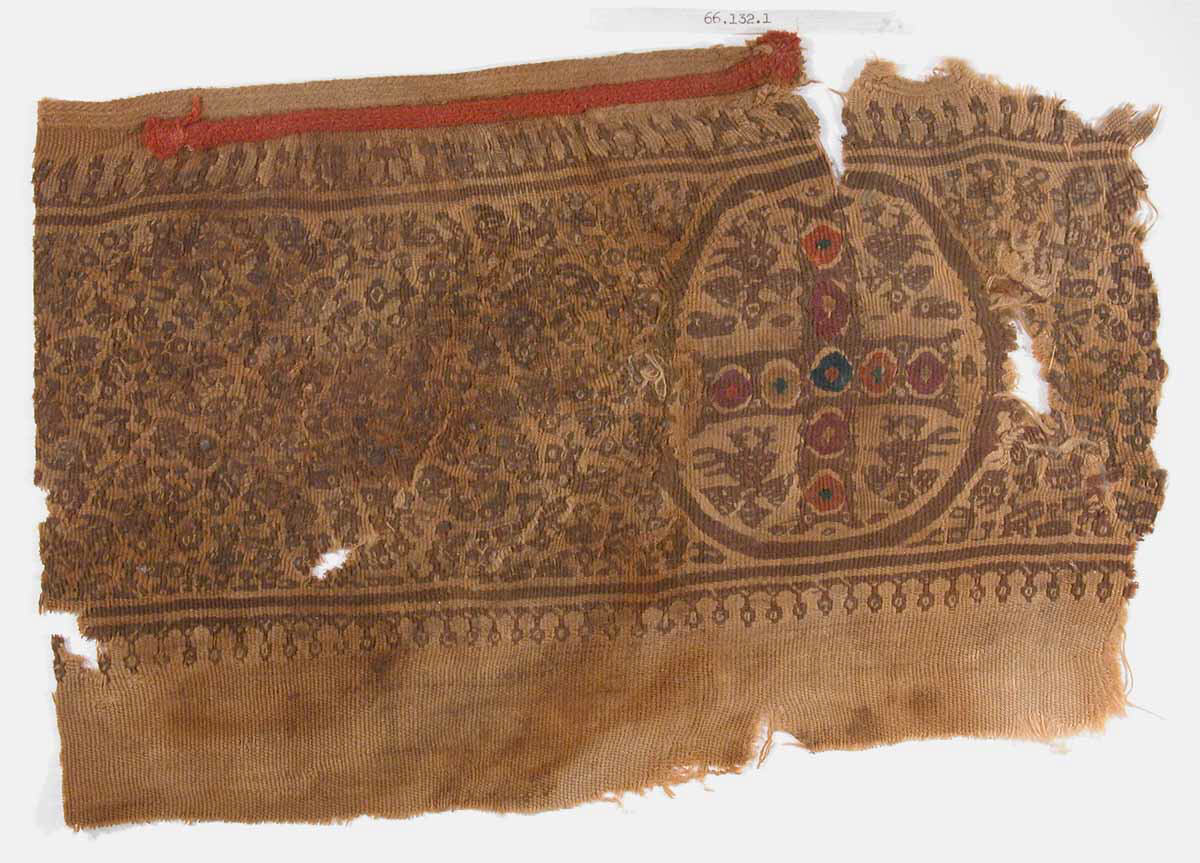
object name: textile fragment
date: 801-900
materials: linen, wool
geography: egypt